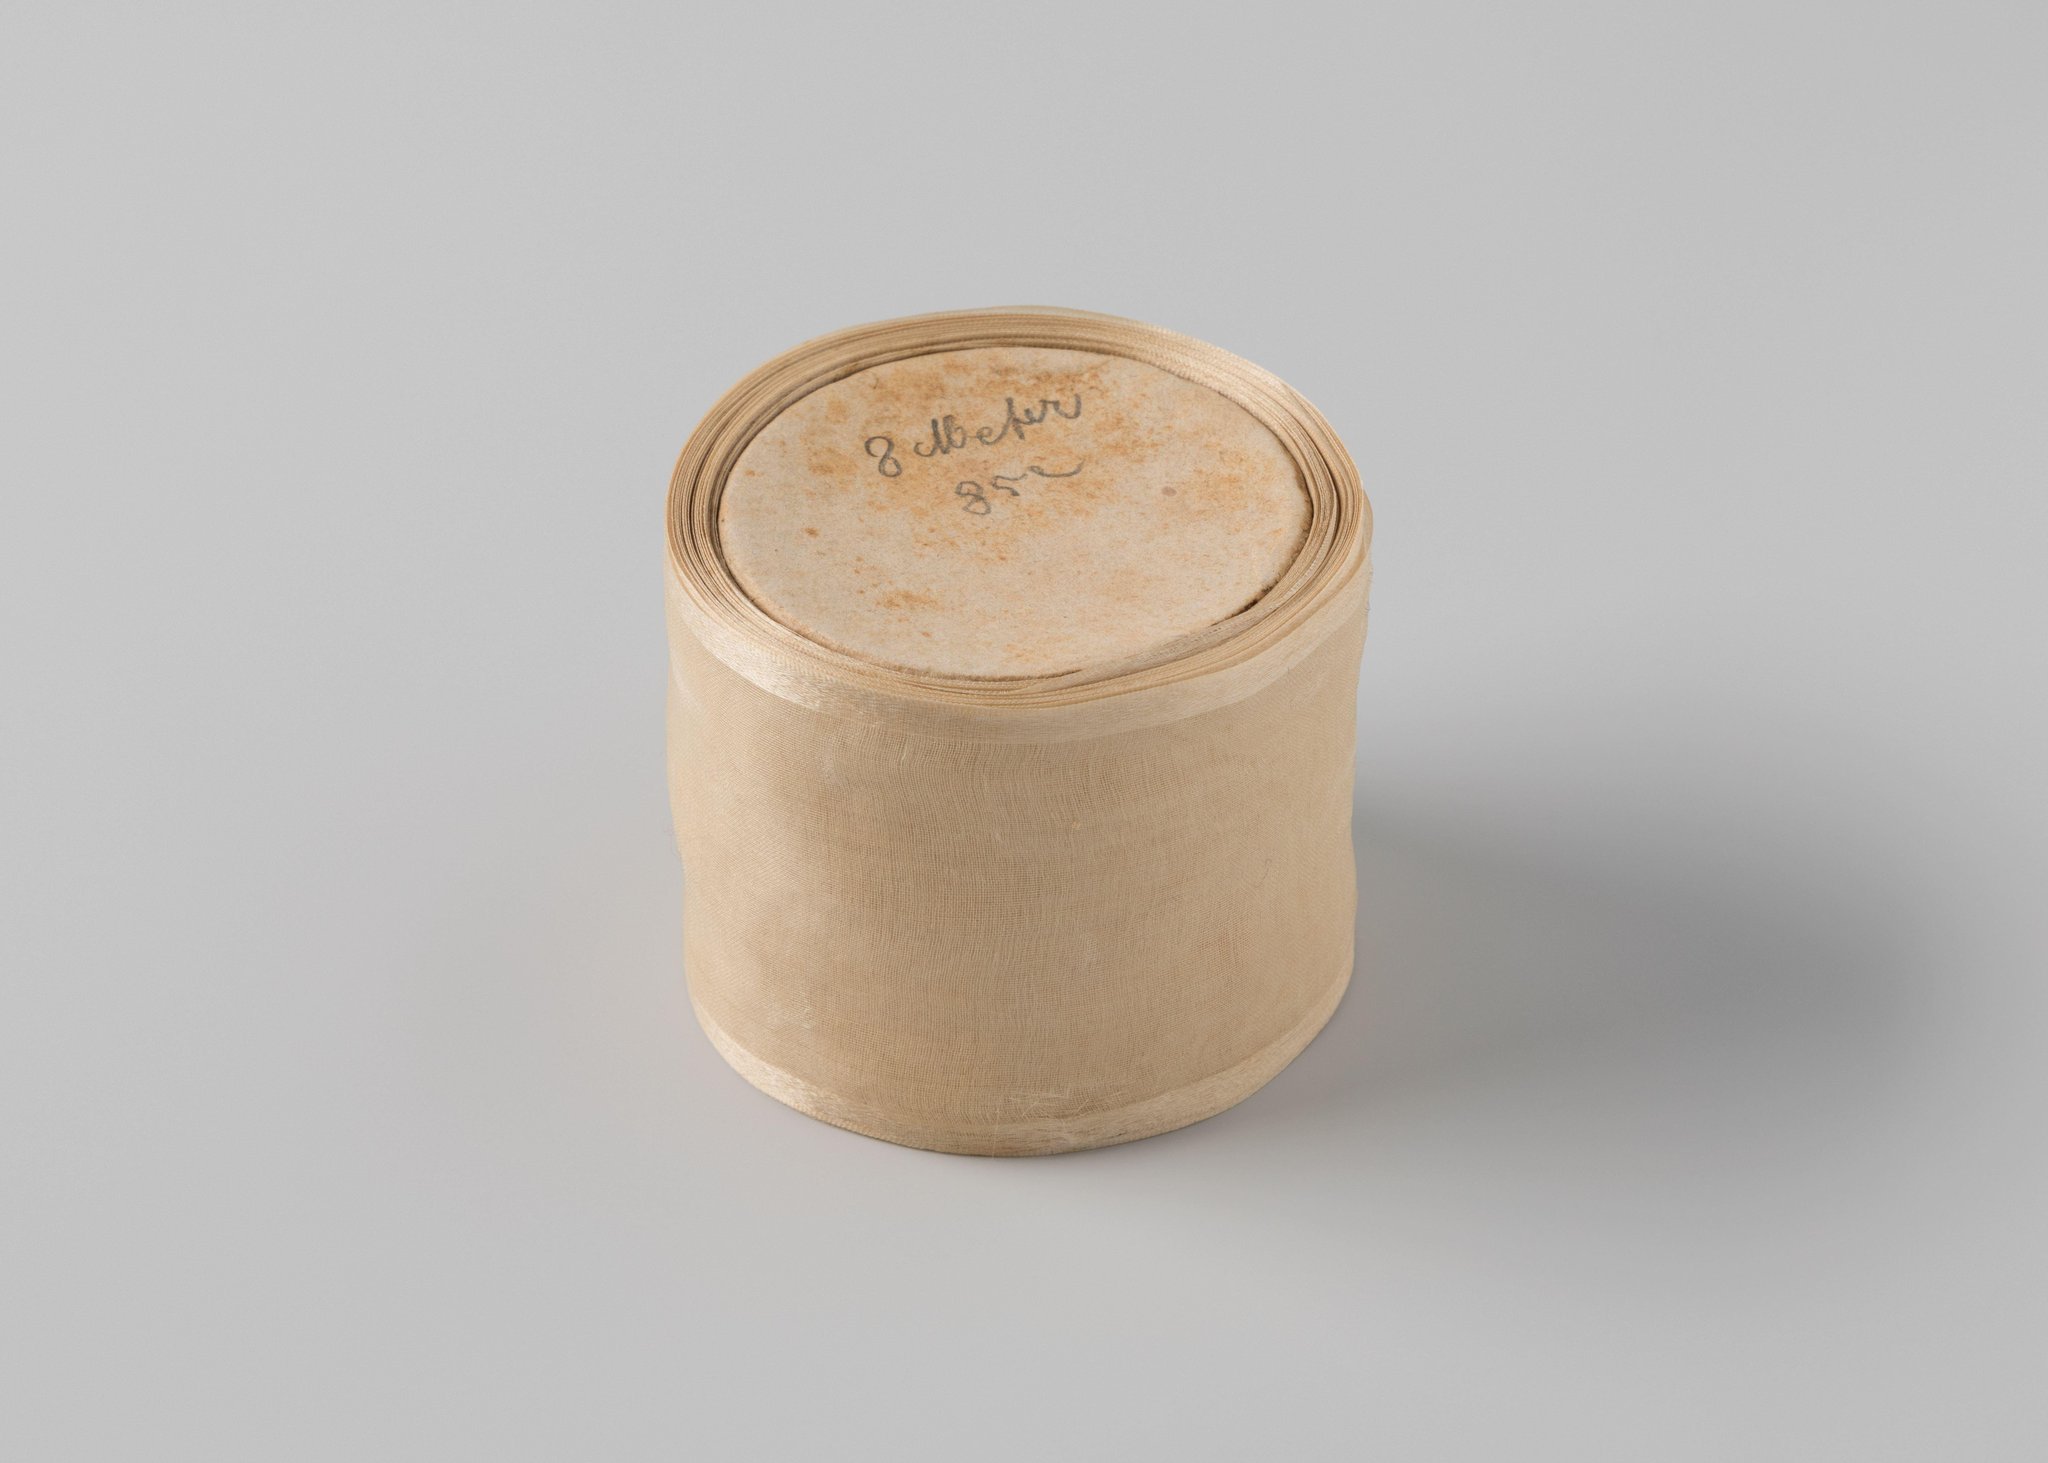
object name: braid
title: Lint van crèmekleurig gaas van 8 meter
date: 1900-1915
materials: textile, silk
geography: nijmegen